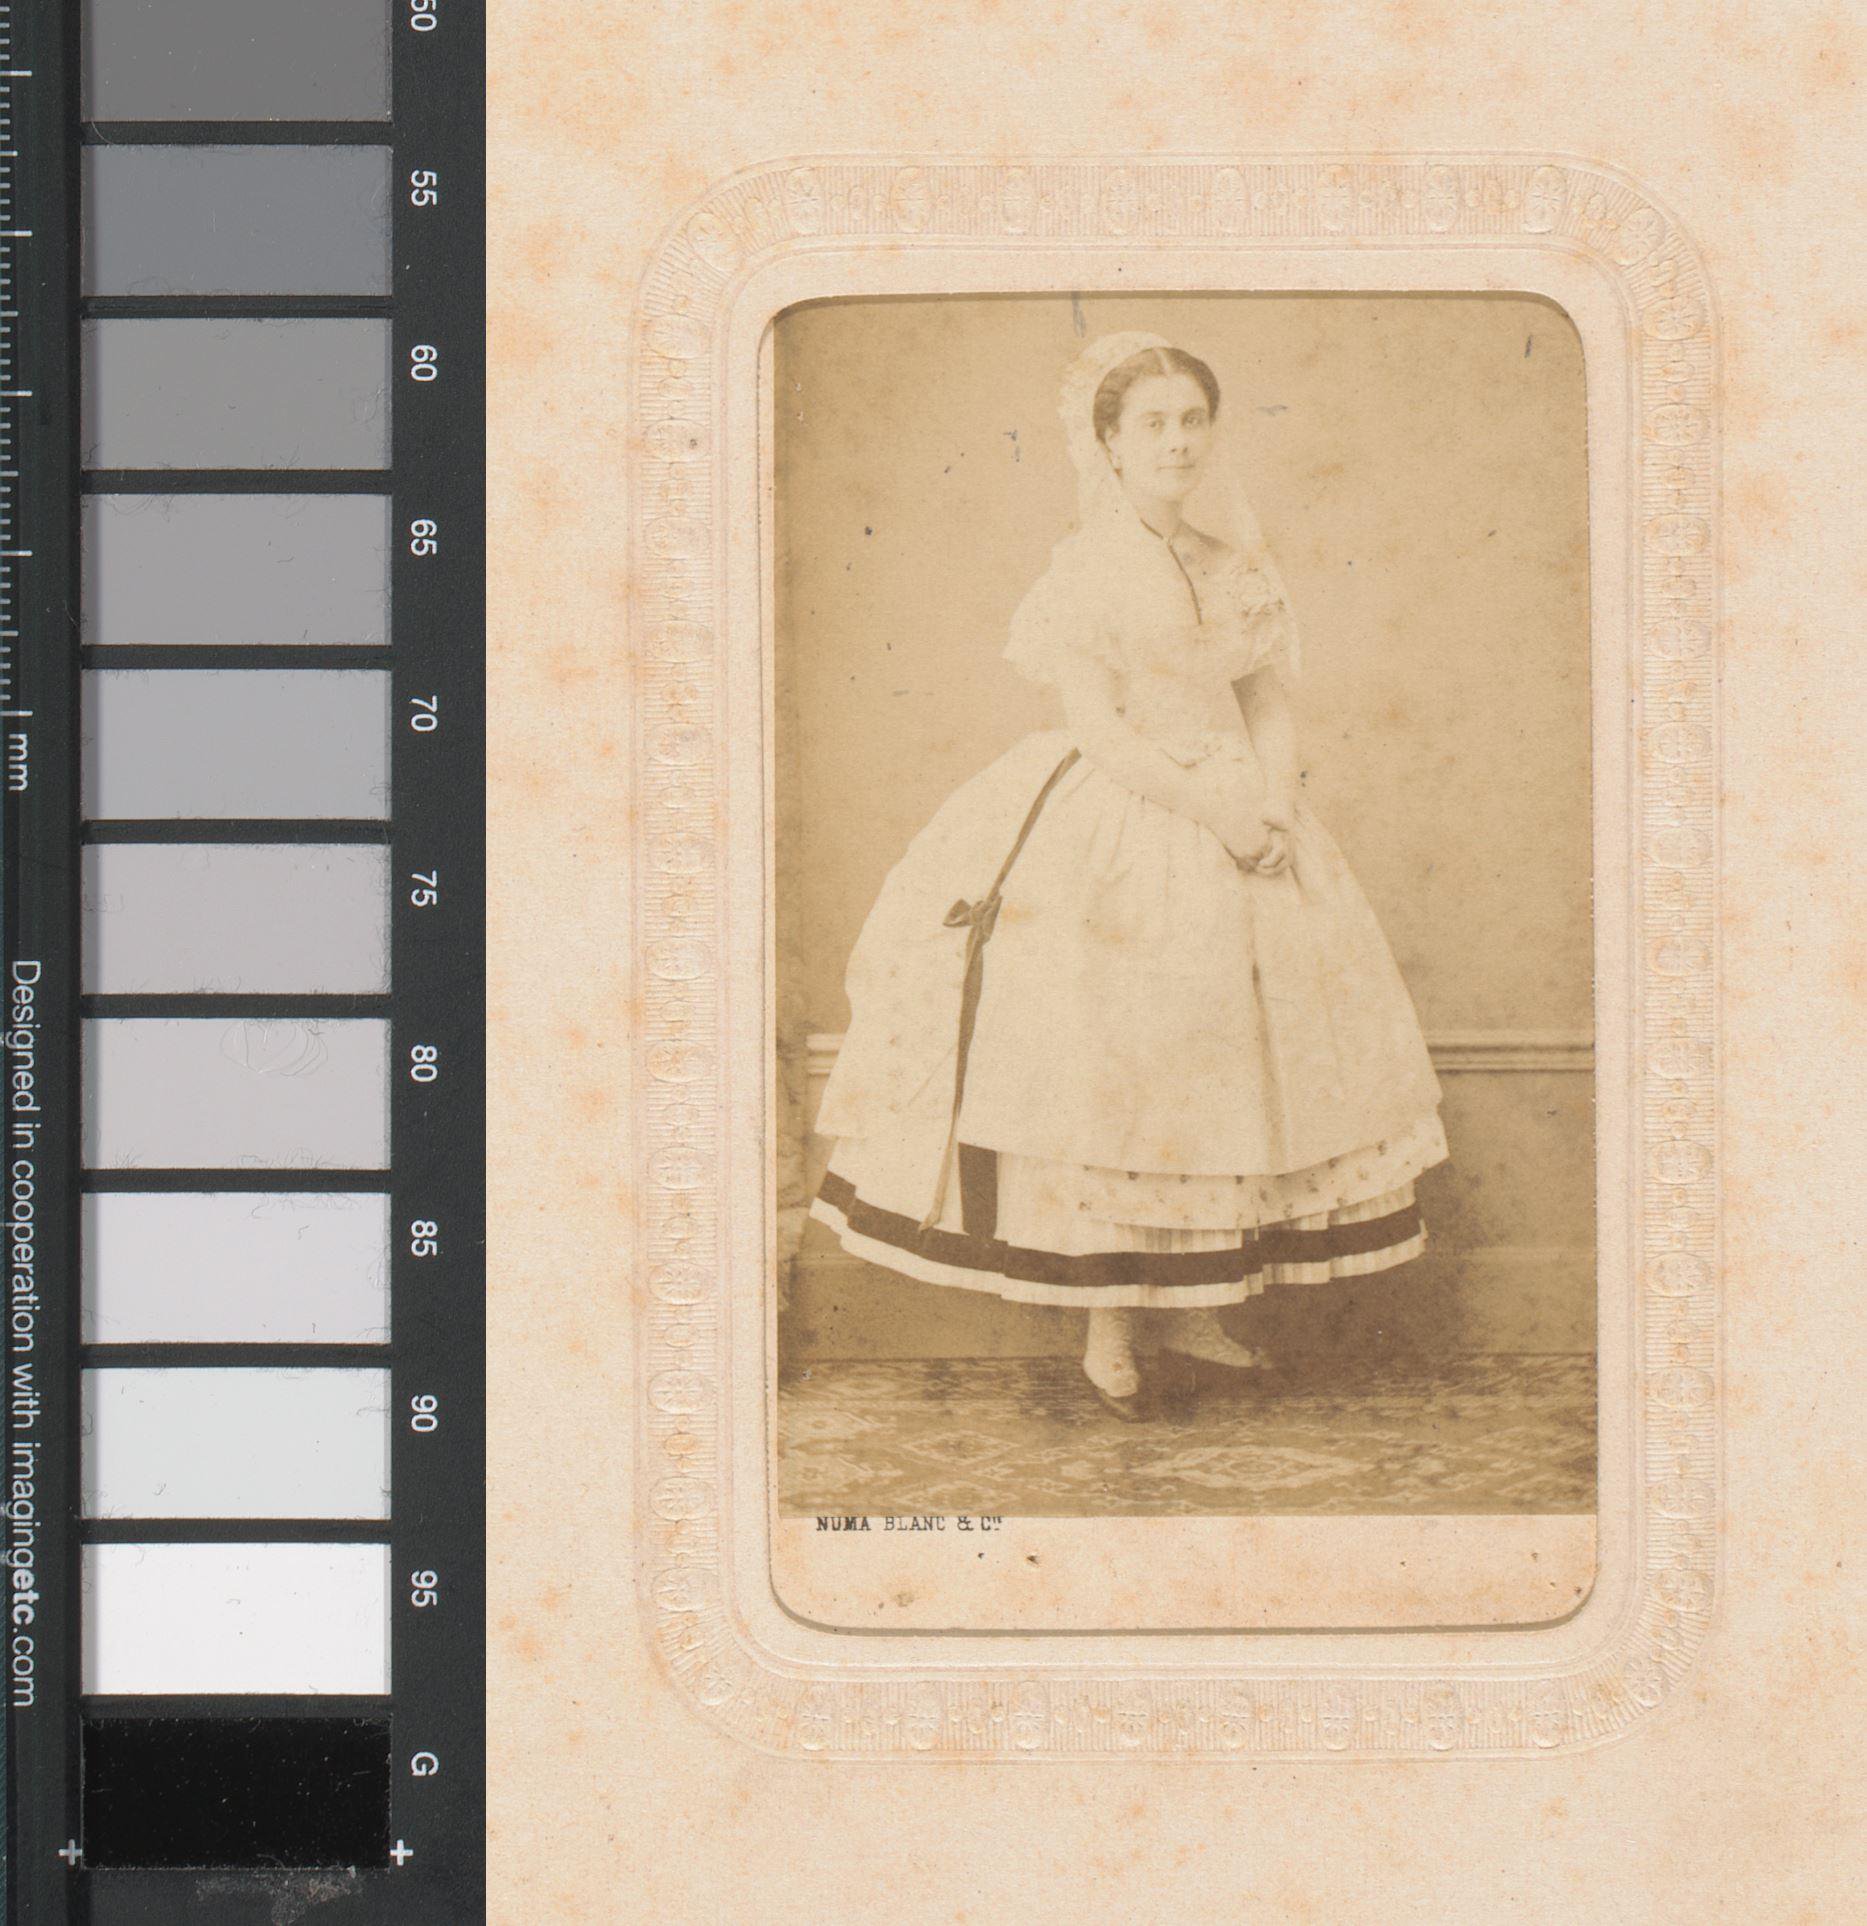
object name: photograph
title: Portret van een vrouw in een jurk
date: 1855-1865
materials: cardboard, photographic support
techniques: albumen print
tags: historical persons - bb - woman